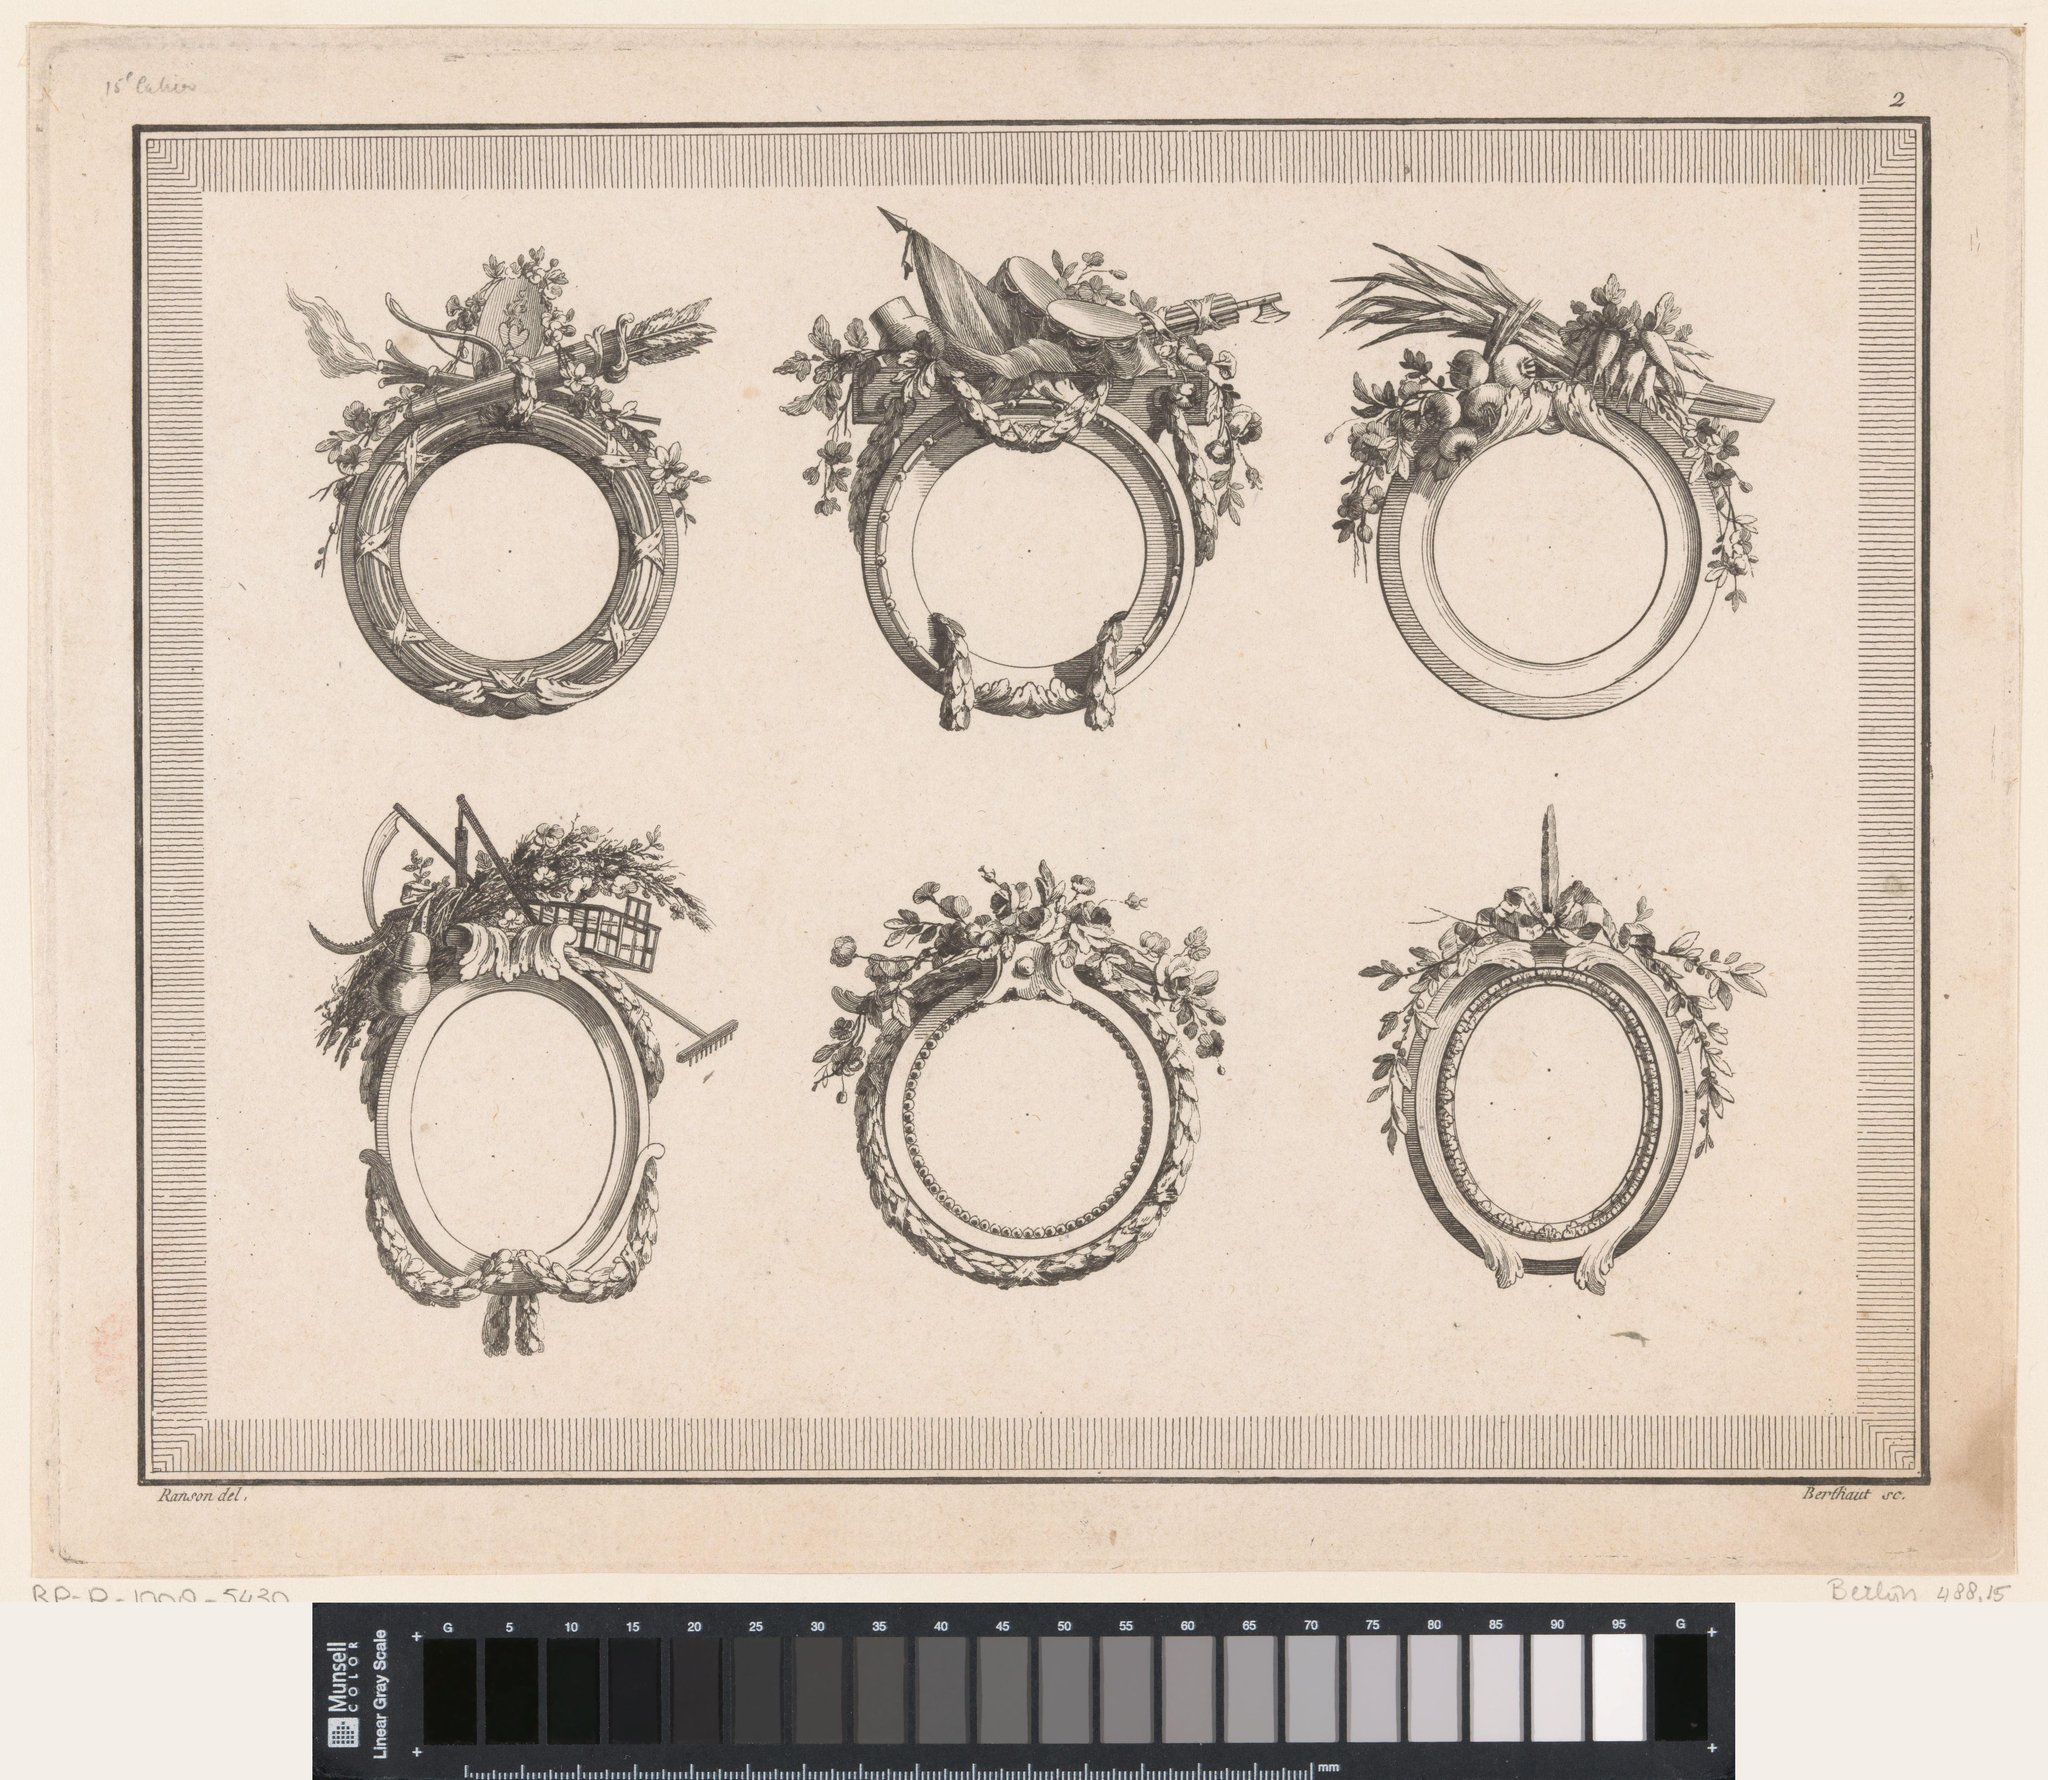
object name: print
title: 15e Cahier de Trophées de l'Oeuvre de Ranson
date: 1778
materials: paper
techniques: etching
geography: paris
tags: ornament ~ medallion, weapons, agricultural implements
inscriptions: collector's mark: Lugt 2228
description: Zes medaillons. Links boven met fakkel, pijlenkoker, boog en schild met harten. Midden boven met wapens, vlag en trommels. Rechts boven met groente. Links onder met agrarische objecten. Midden- en rechts onder met (bloemen)ranken.